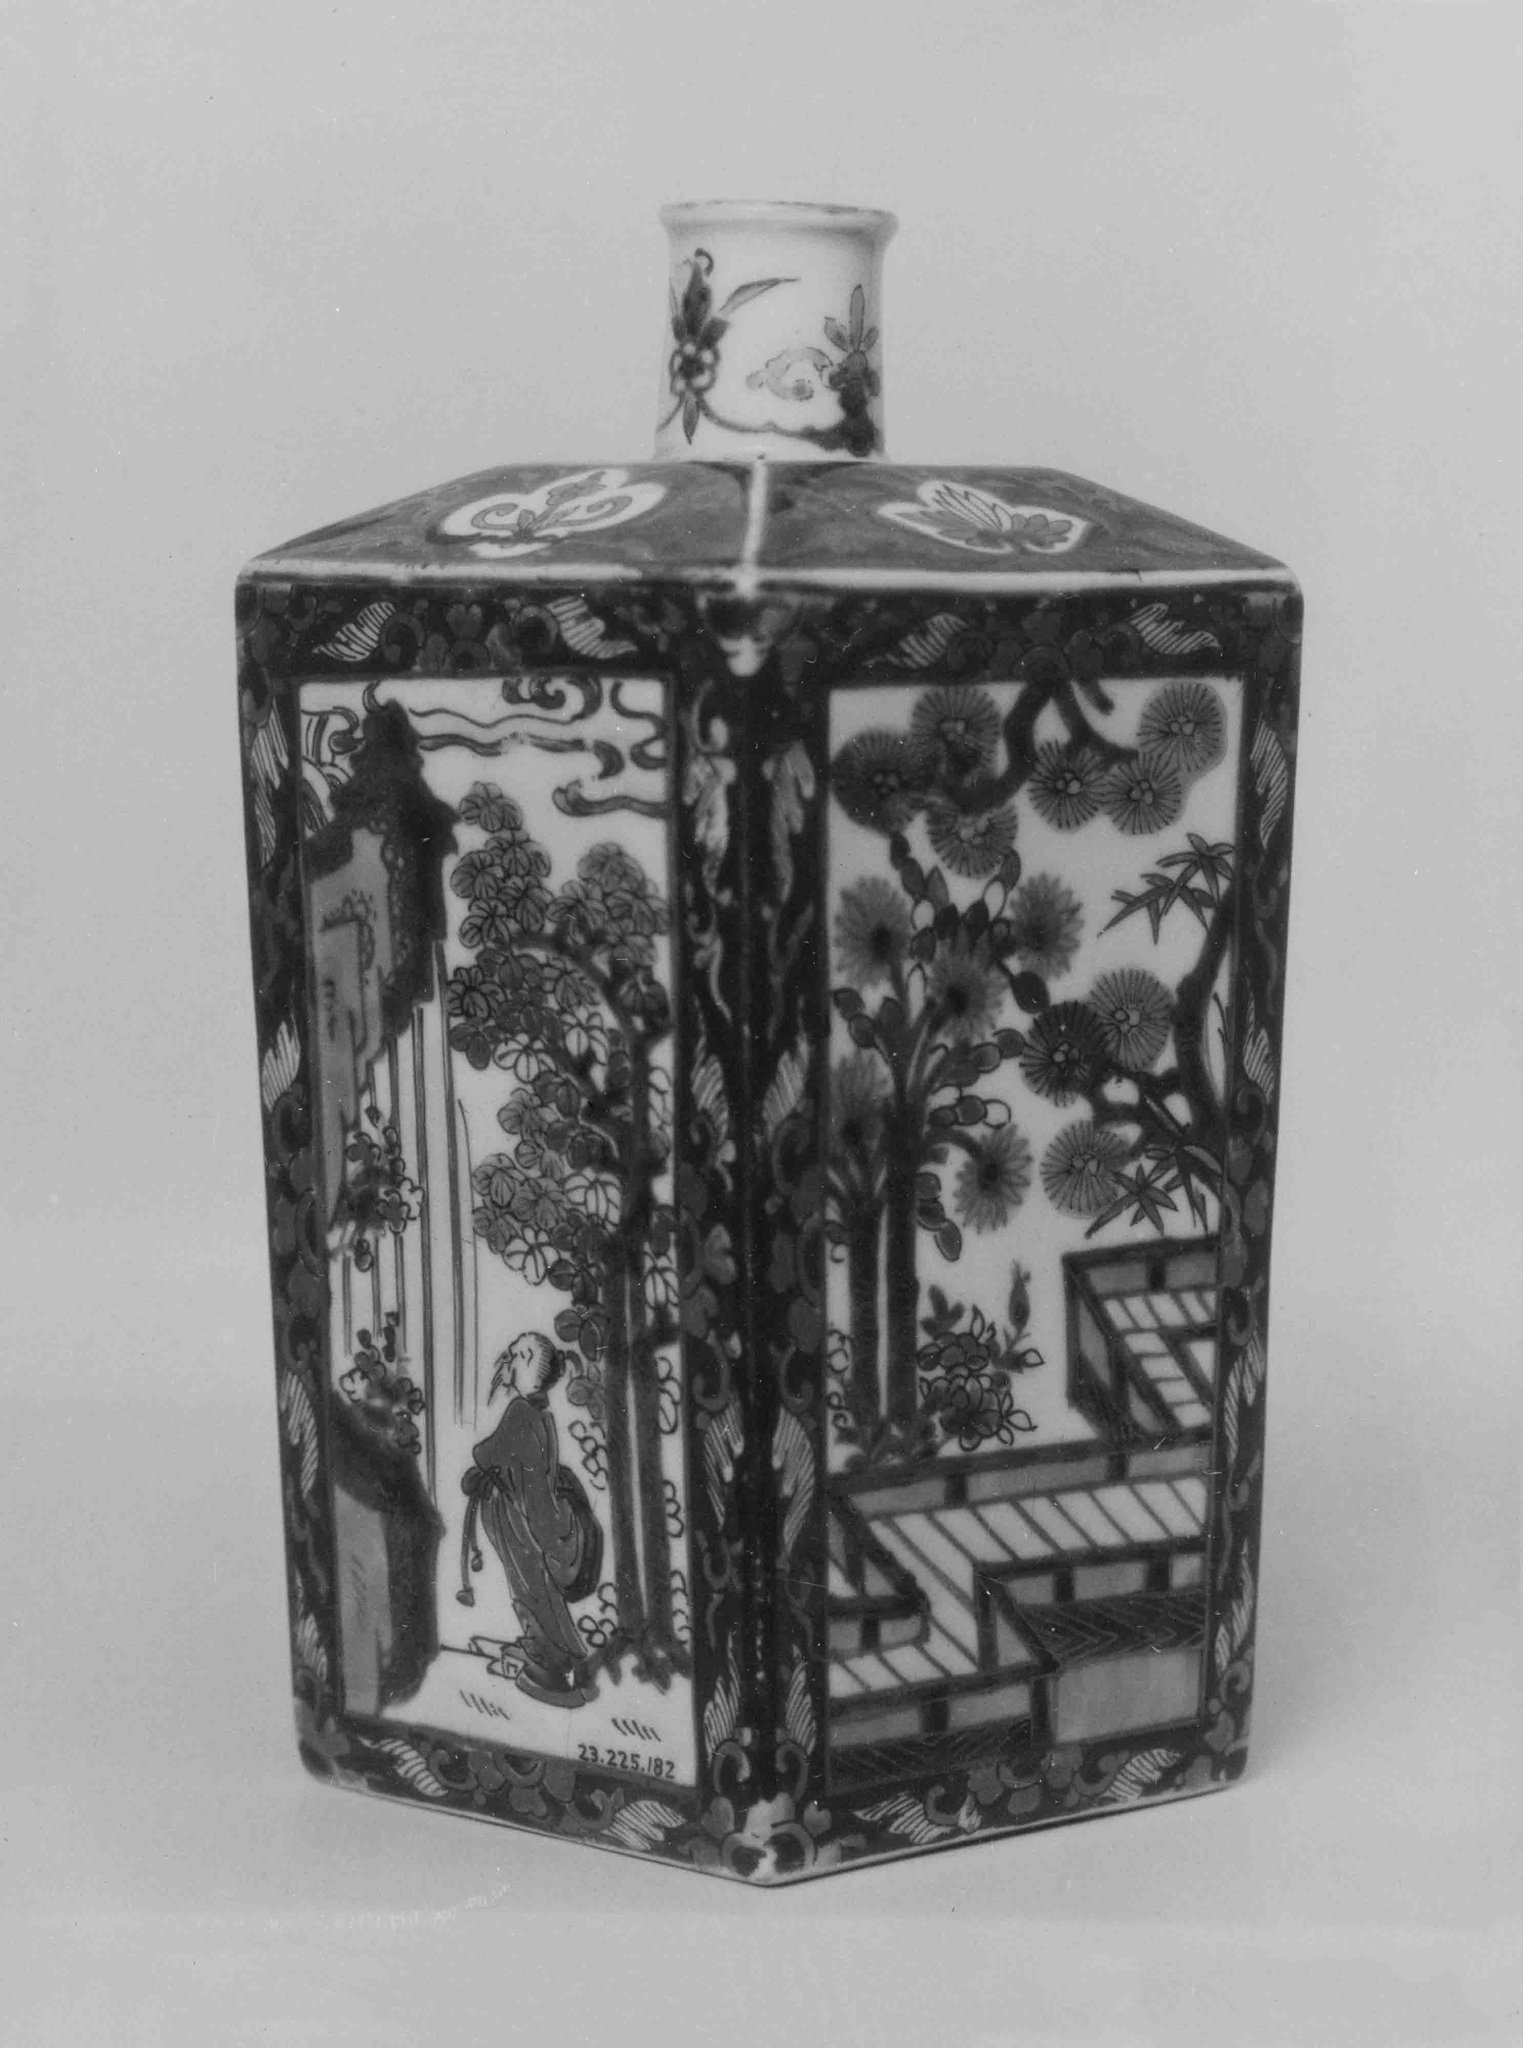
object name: square flask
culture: japanese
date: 1701-1800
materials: enamel, porcelain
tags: human figures,flowers